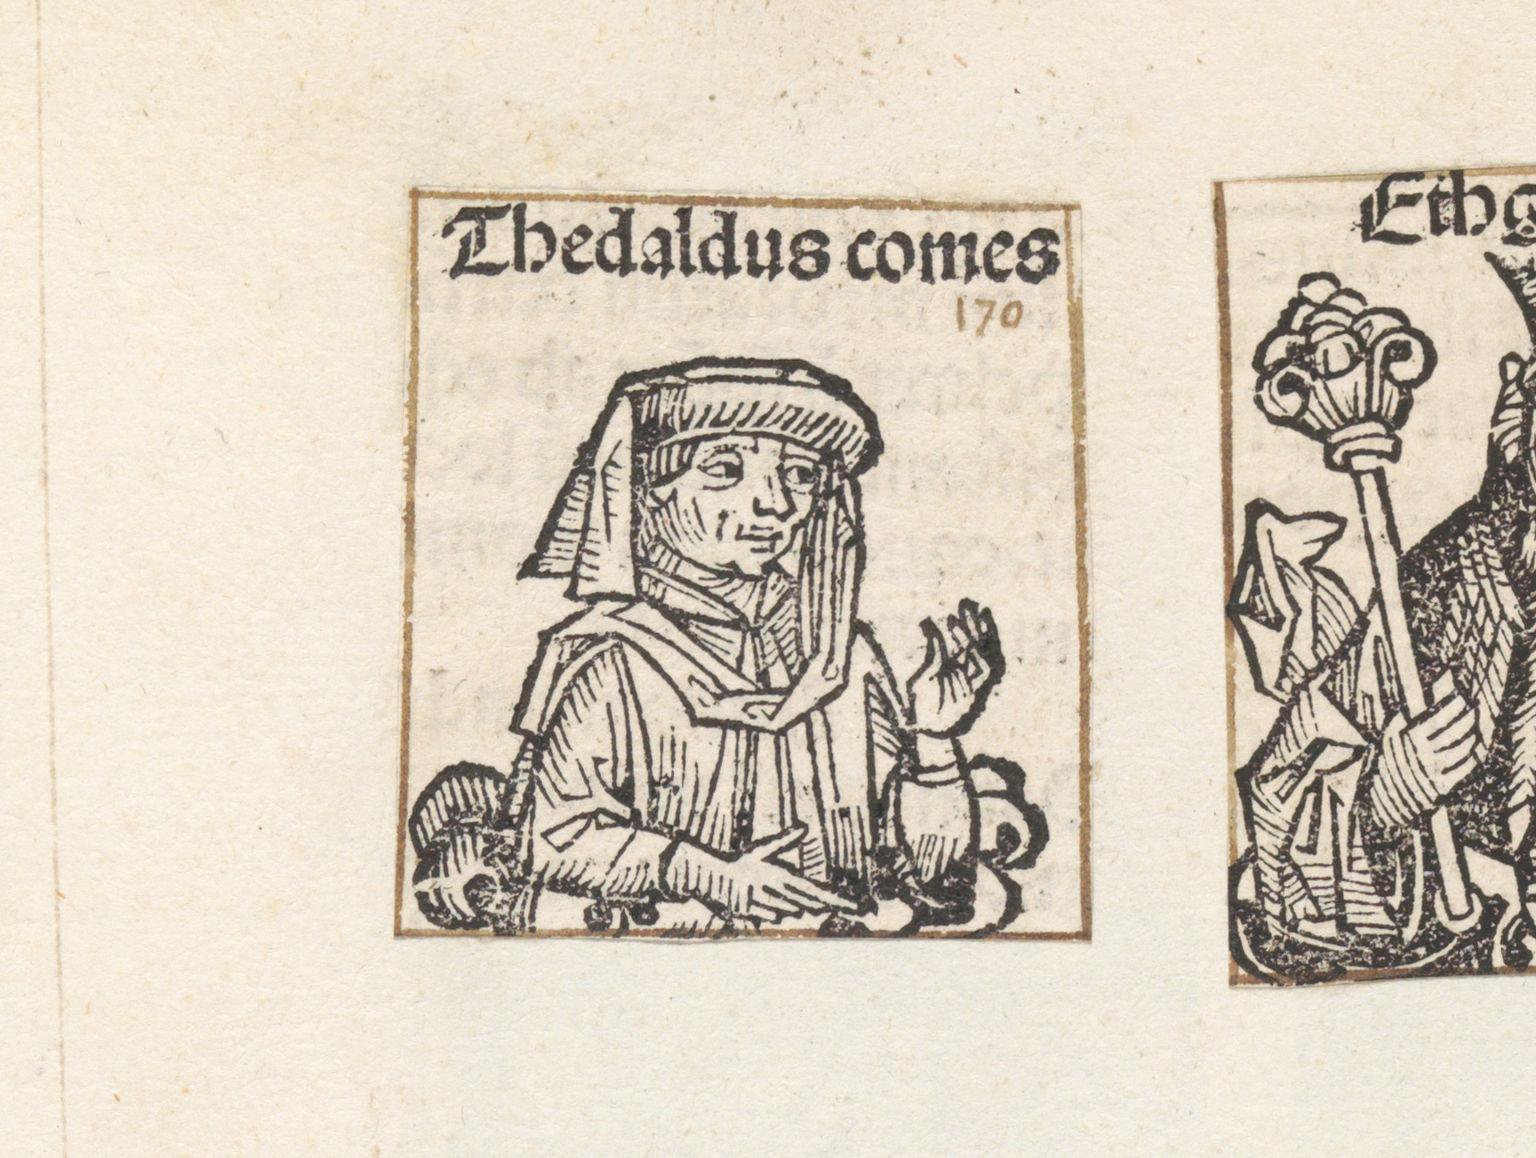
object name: print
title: Liber Chronicarum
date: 1493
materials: paper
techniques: letterpress printing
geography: nuremberg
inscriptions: inscription: ‘170’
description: De houtsnede wordt herhaaldelijk gebruikt als boekillustratie in de Liber Chronicarum (of Neurenbergkroniek) van Hartmann Schedel, verschenen in het Latijn en Duits in 1493. Zie de Latijnse uitgave, folio 181r.